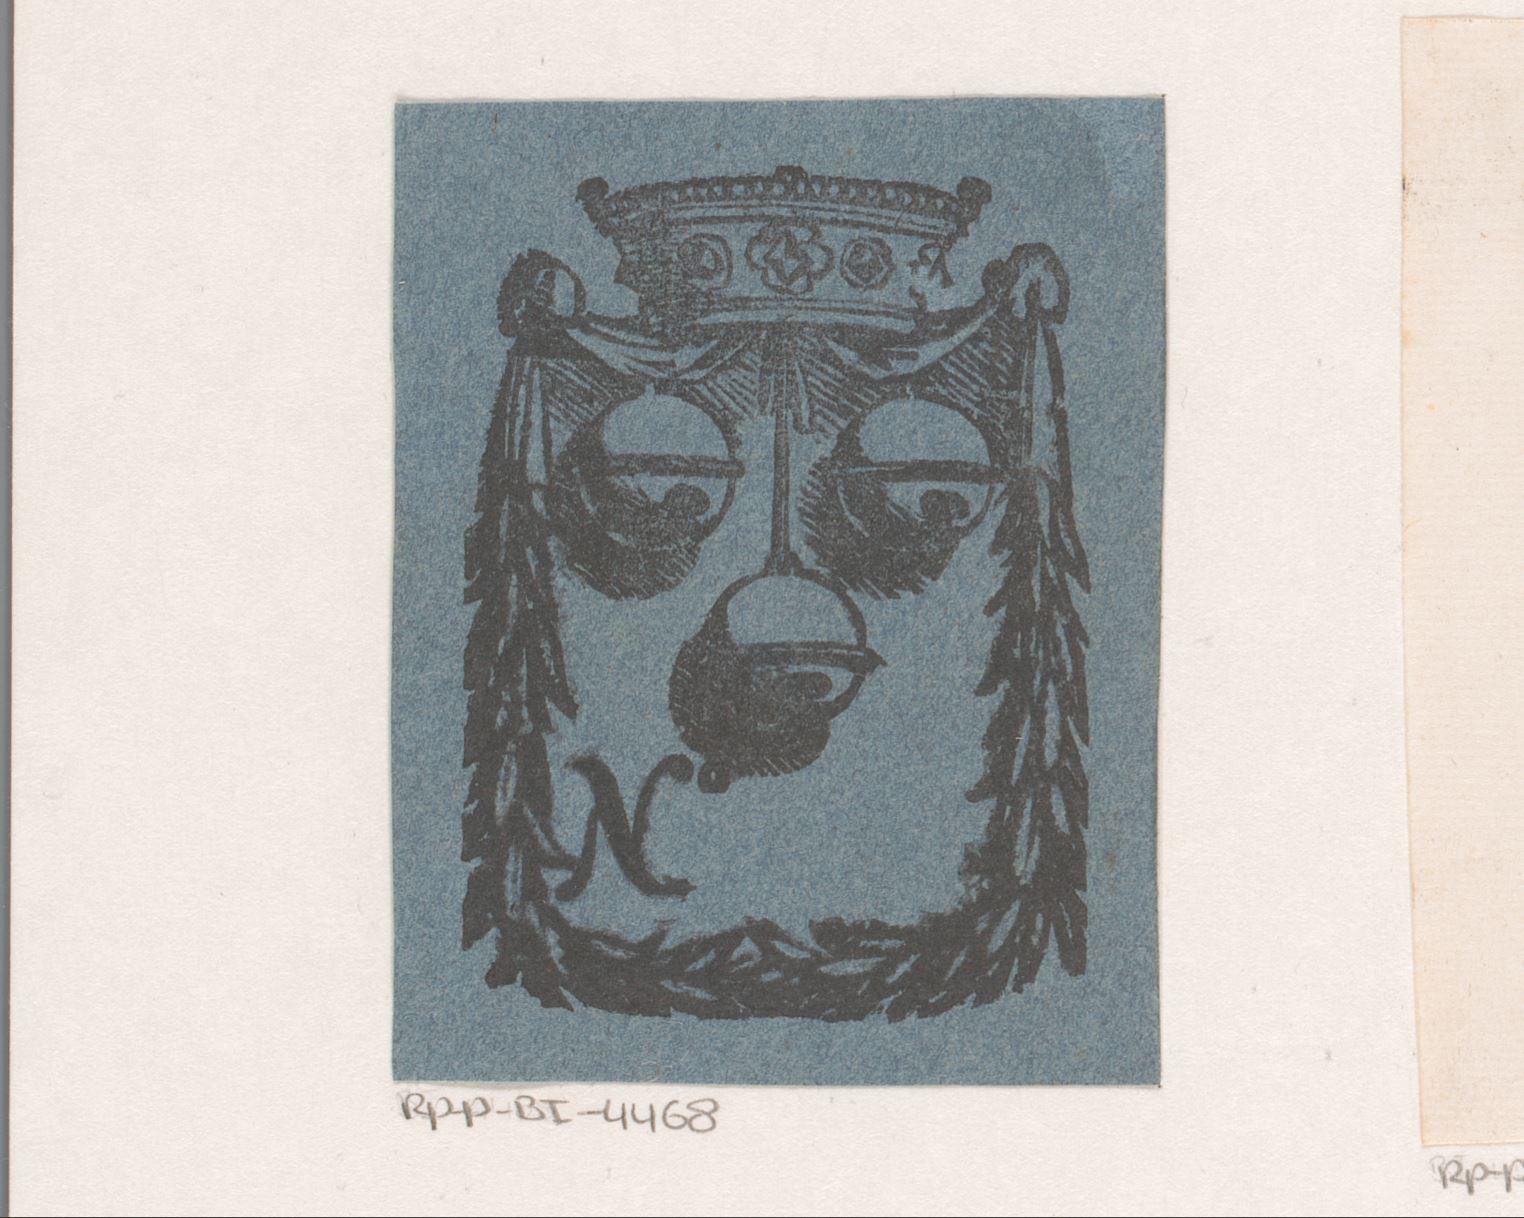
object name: print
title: Vignet met drie bellen en een kroon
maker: Anonymous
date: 1600-1699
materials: paper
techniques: woodcut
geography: netherlands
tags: crown (symbol of sovereignty), vignette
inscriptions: collector's mark: Lugt 240